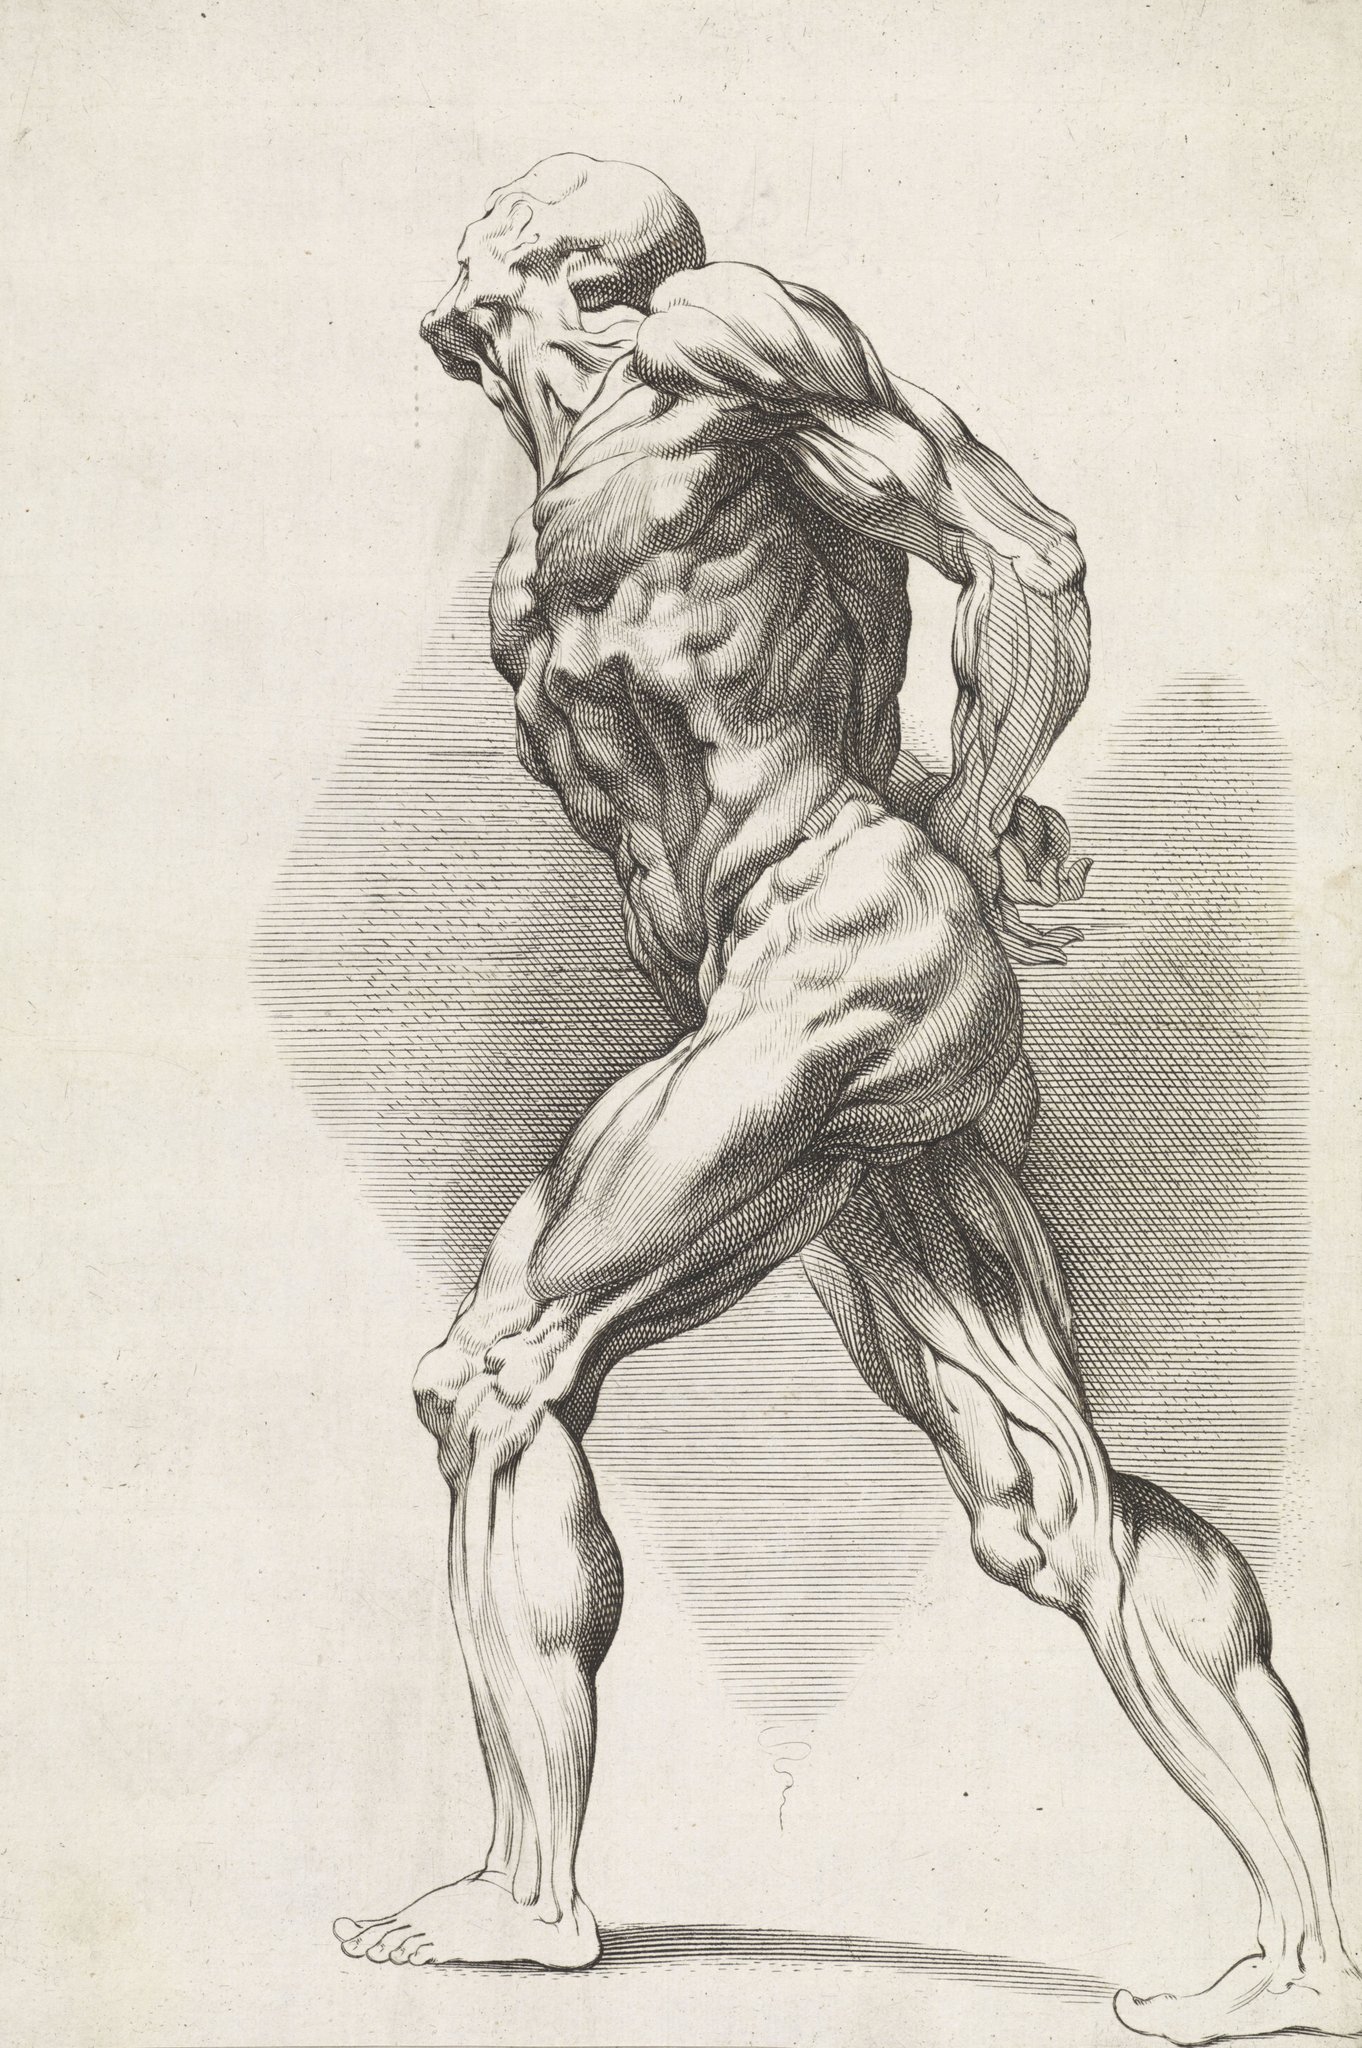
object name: print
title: Het tekenboek van Peter Paul Rubens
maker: paulus pontius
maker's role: draughtsman, print maker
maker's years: 1603-1658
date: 1616-1657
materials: paper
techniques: engraving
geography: antwerp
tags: parts of the human body (skeleton excepted)